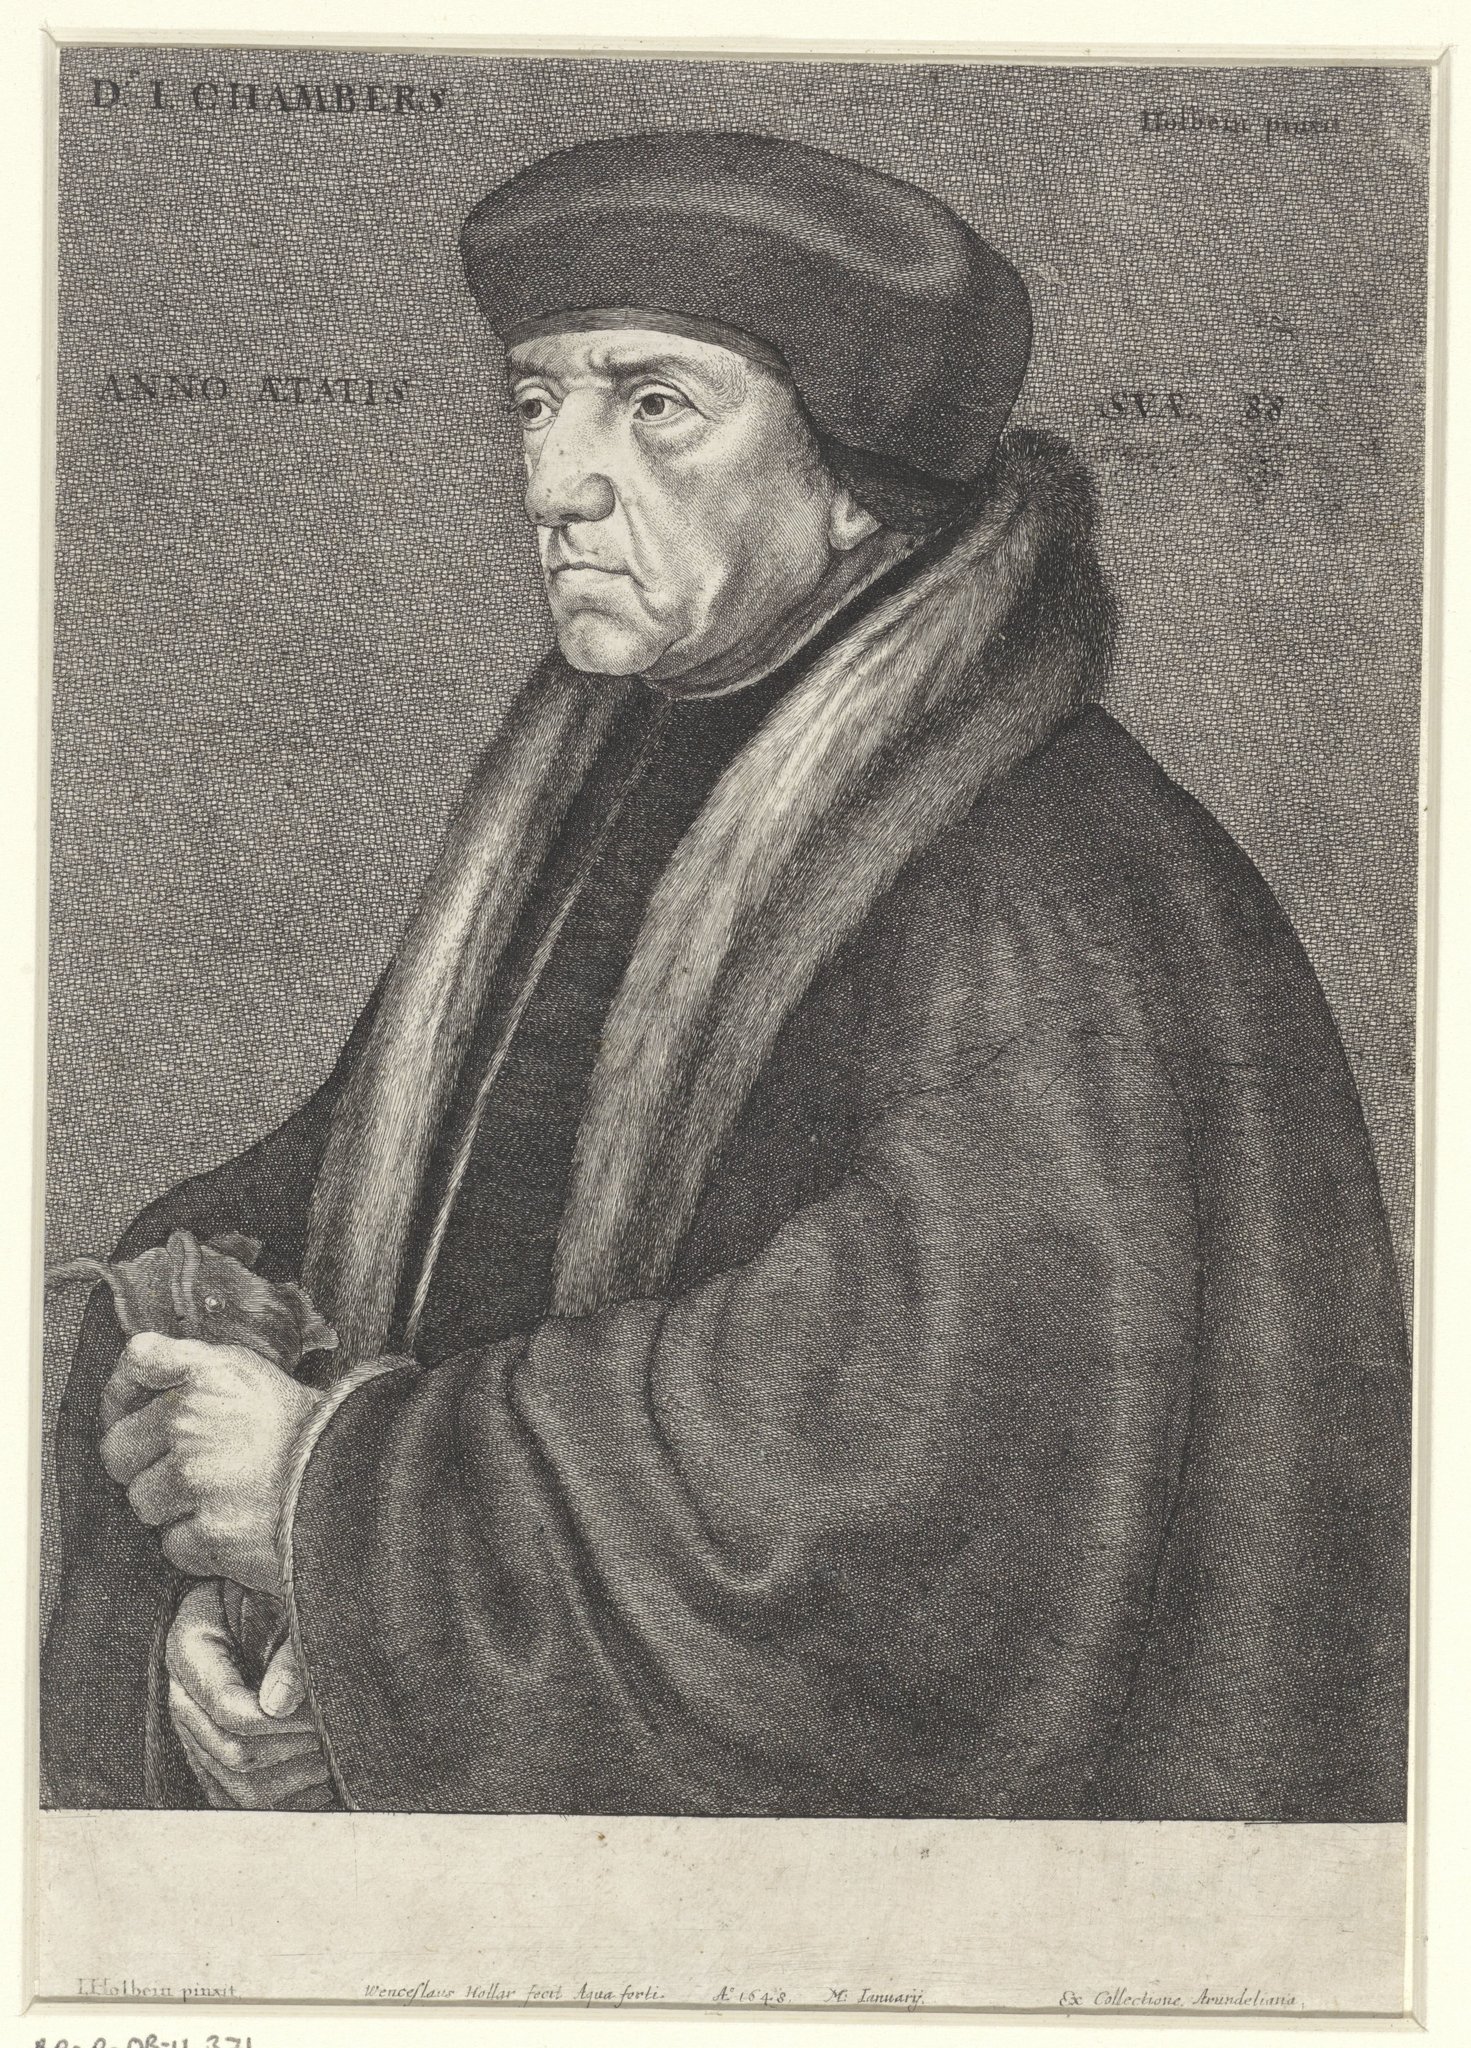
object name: print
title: Portret van John Chamber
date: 1648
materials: paper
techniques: etching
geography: antwerp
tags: arts, john chamber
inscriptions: collector's mark: Lugt 384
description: Portret van John Chamber, lijfarts van Hendrik VIII van Engeland.